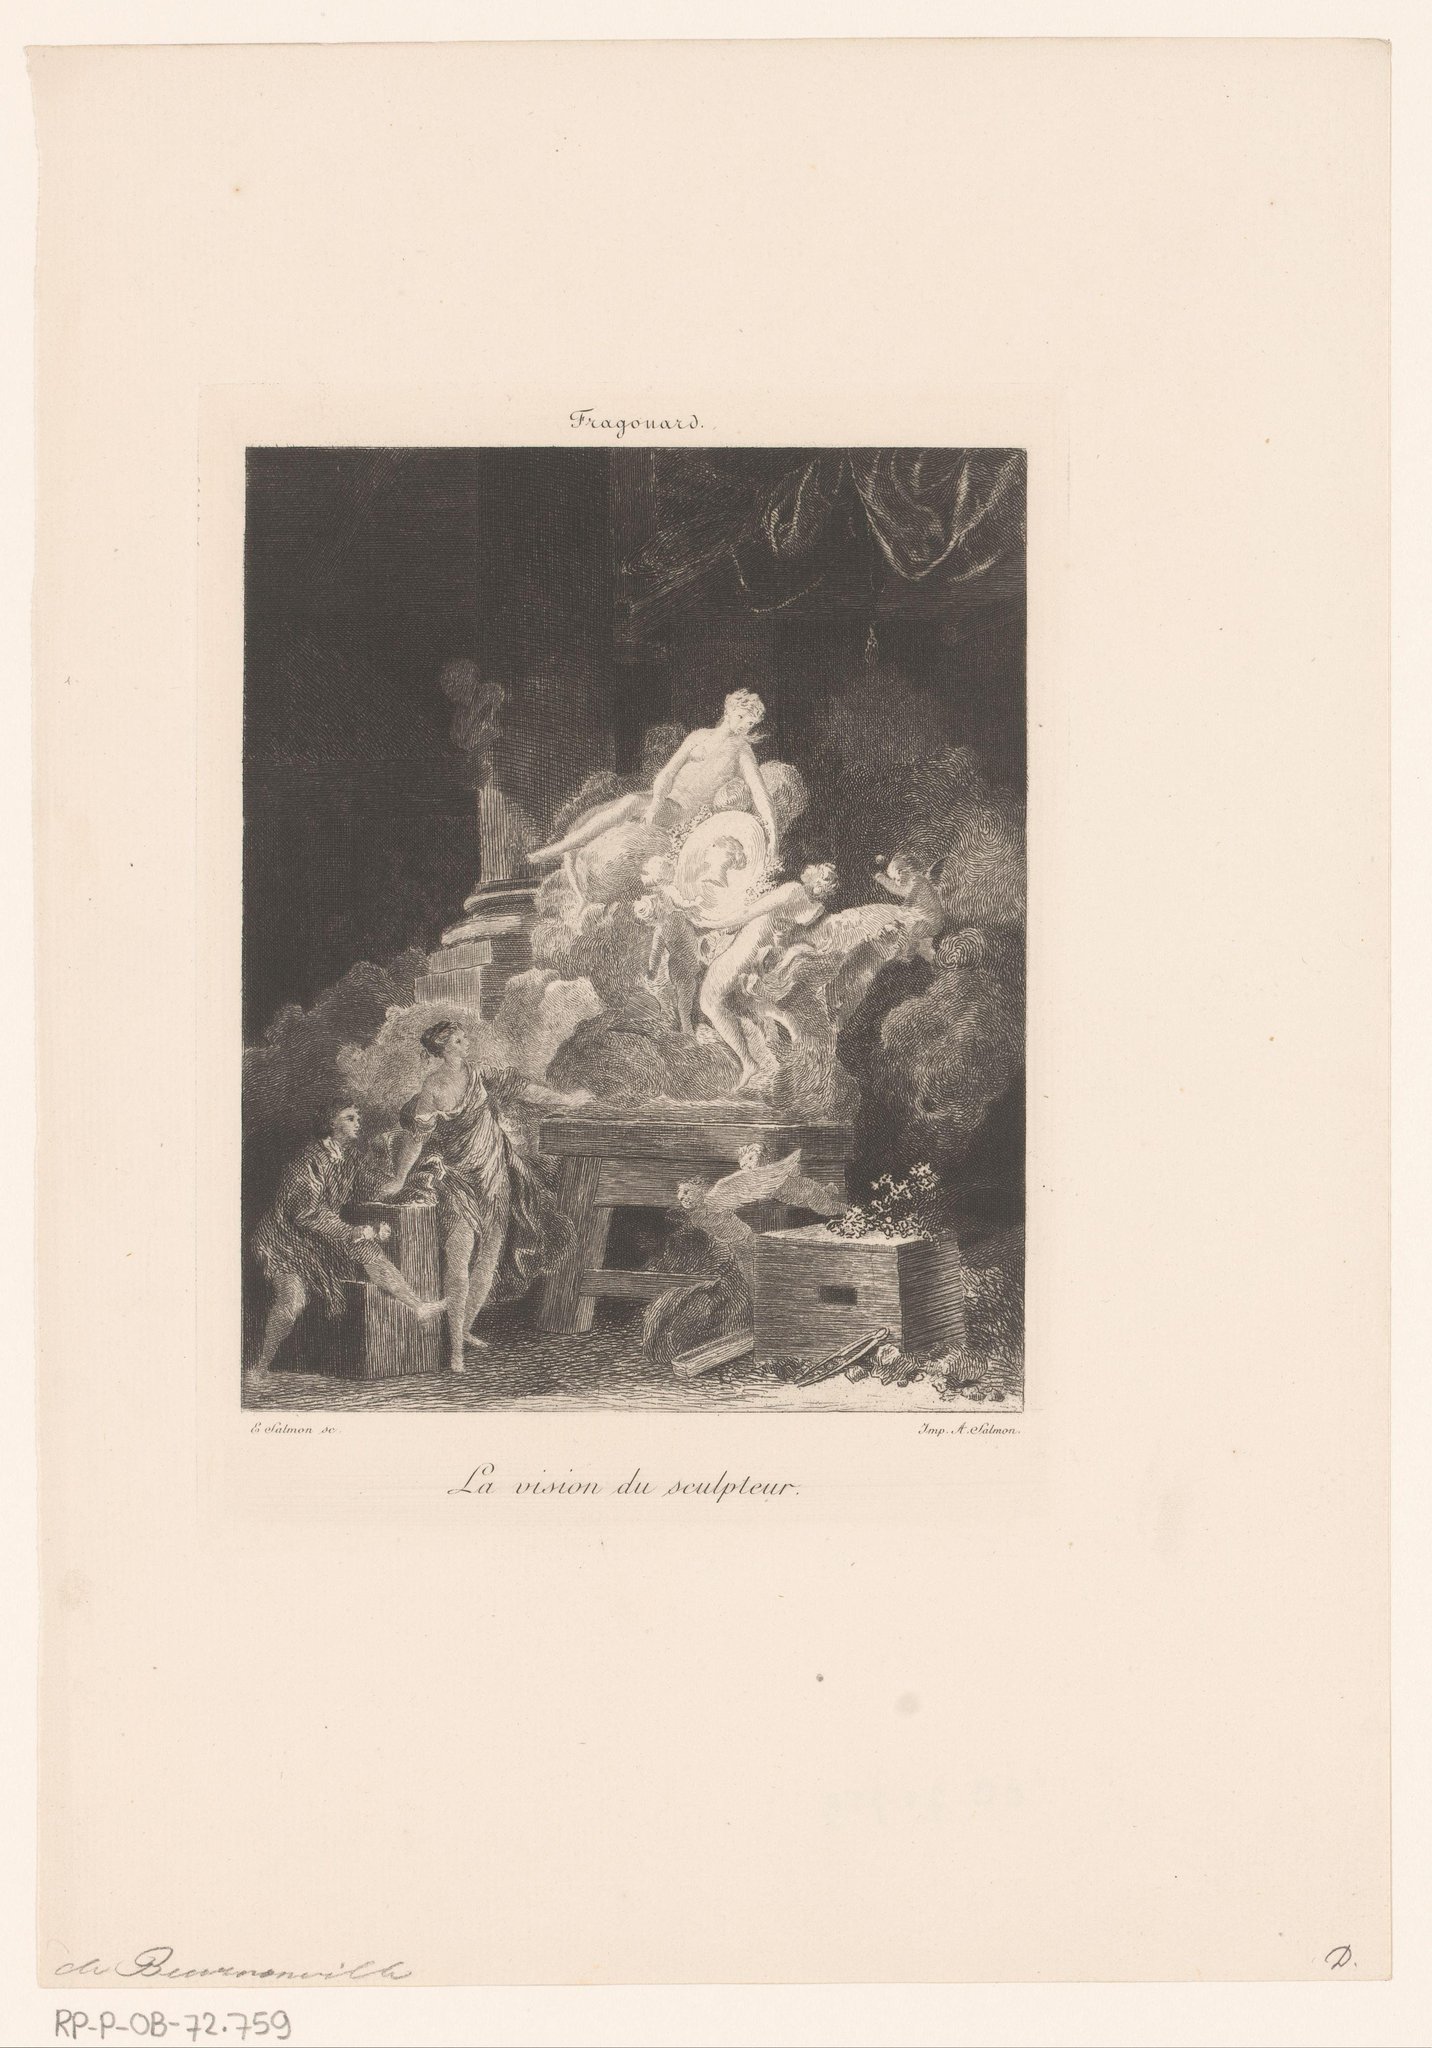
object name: print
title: Werkplaats van een beeldhouwer met een in wolken gehuld visioen van een beeld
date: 1850-1913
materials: paper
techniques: etching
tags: sculptor at work, 'sculptura', symbolic representations, allegories and emblems ~ sculpture; 'scoltura' (ripa), vision, cupids: 'amores', 'amoretti', 'putti'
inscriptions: collector's mark: Lugt 2228